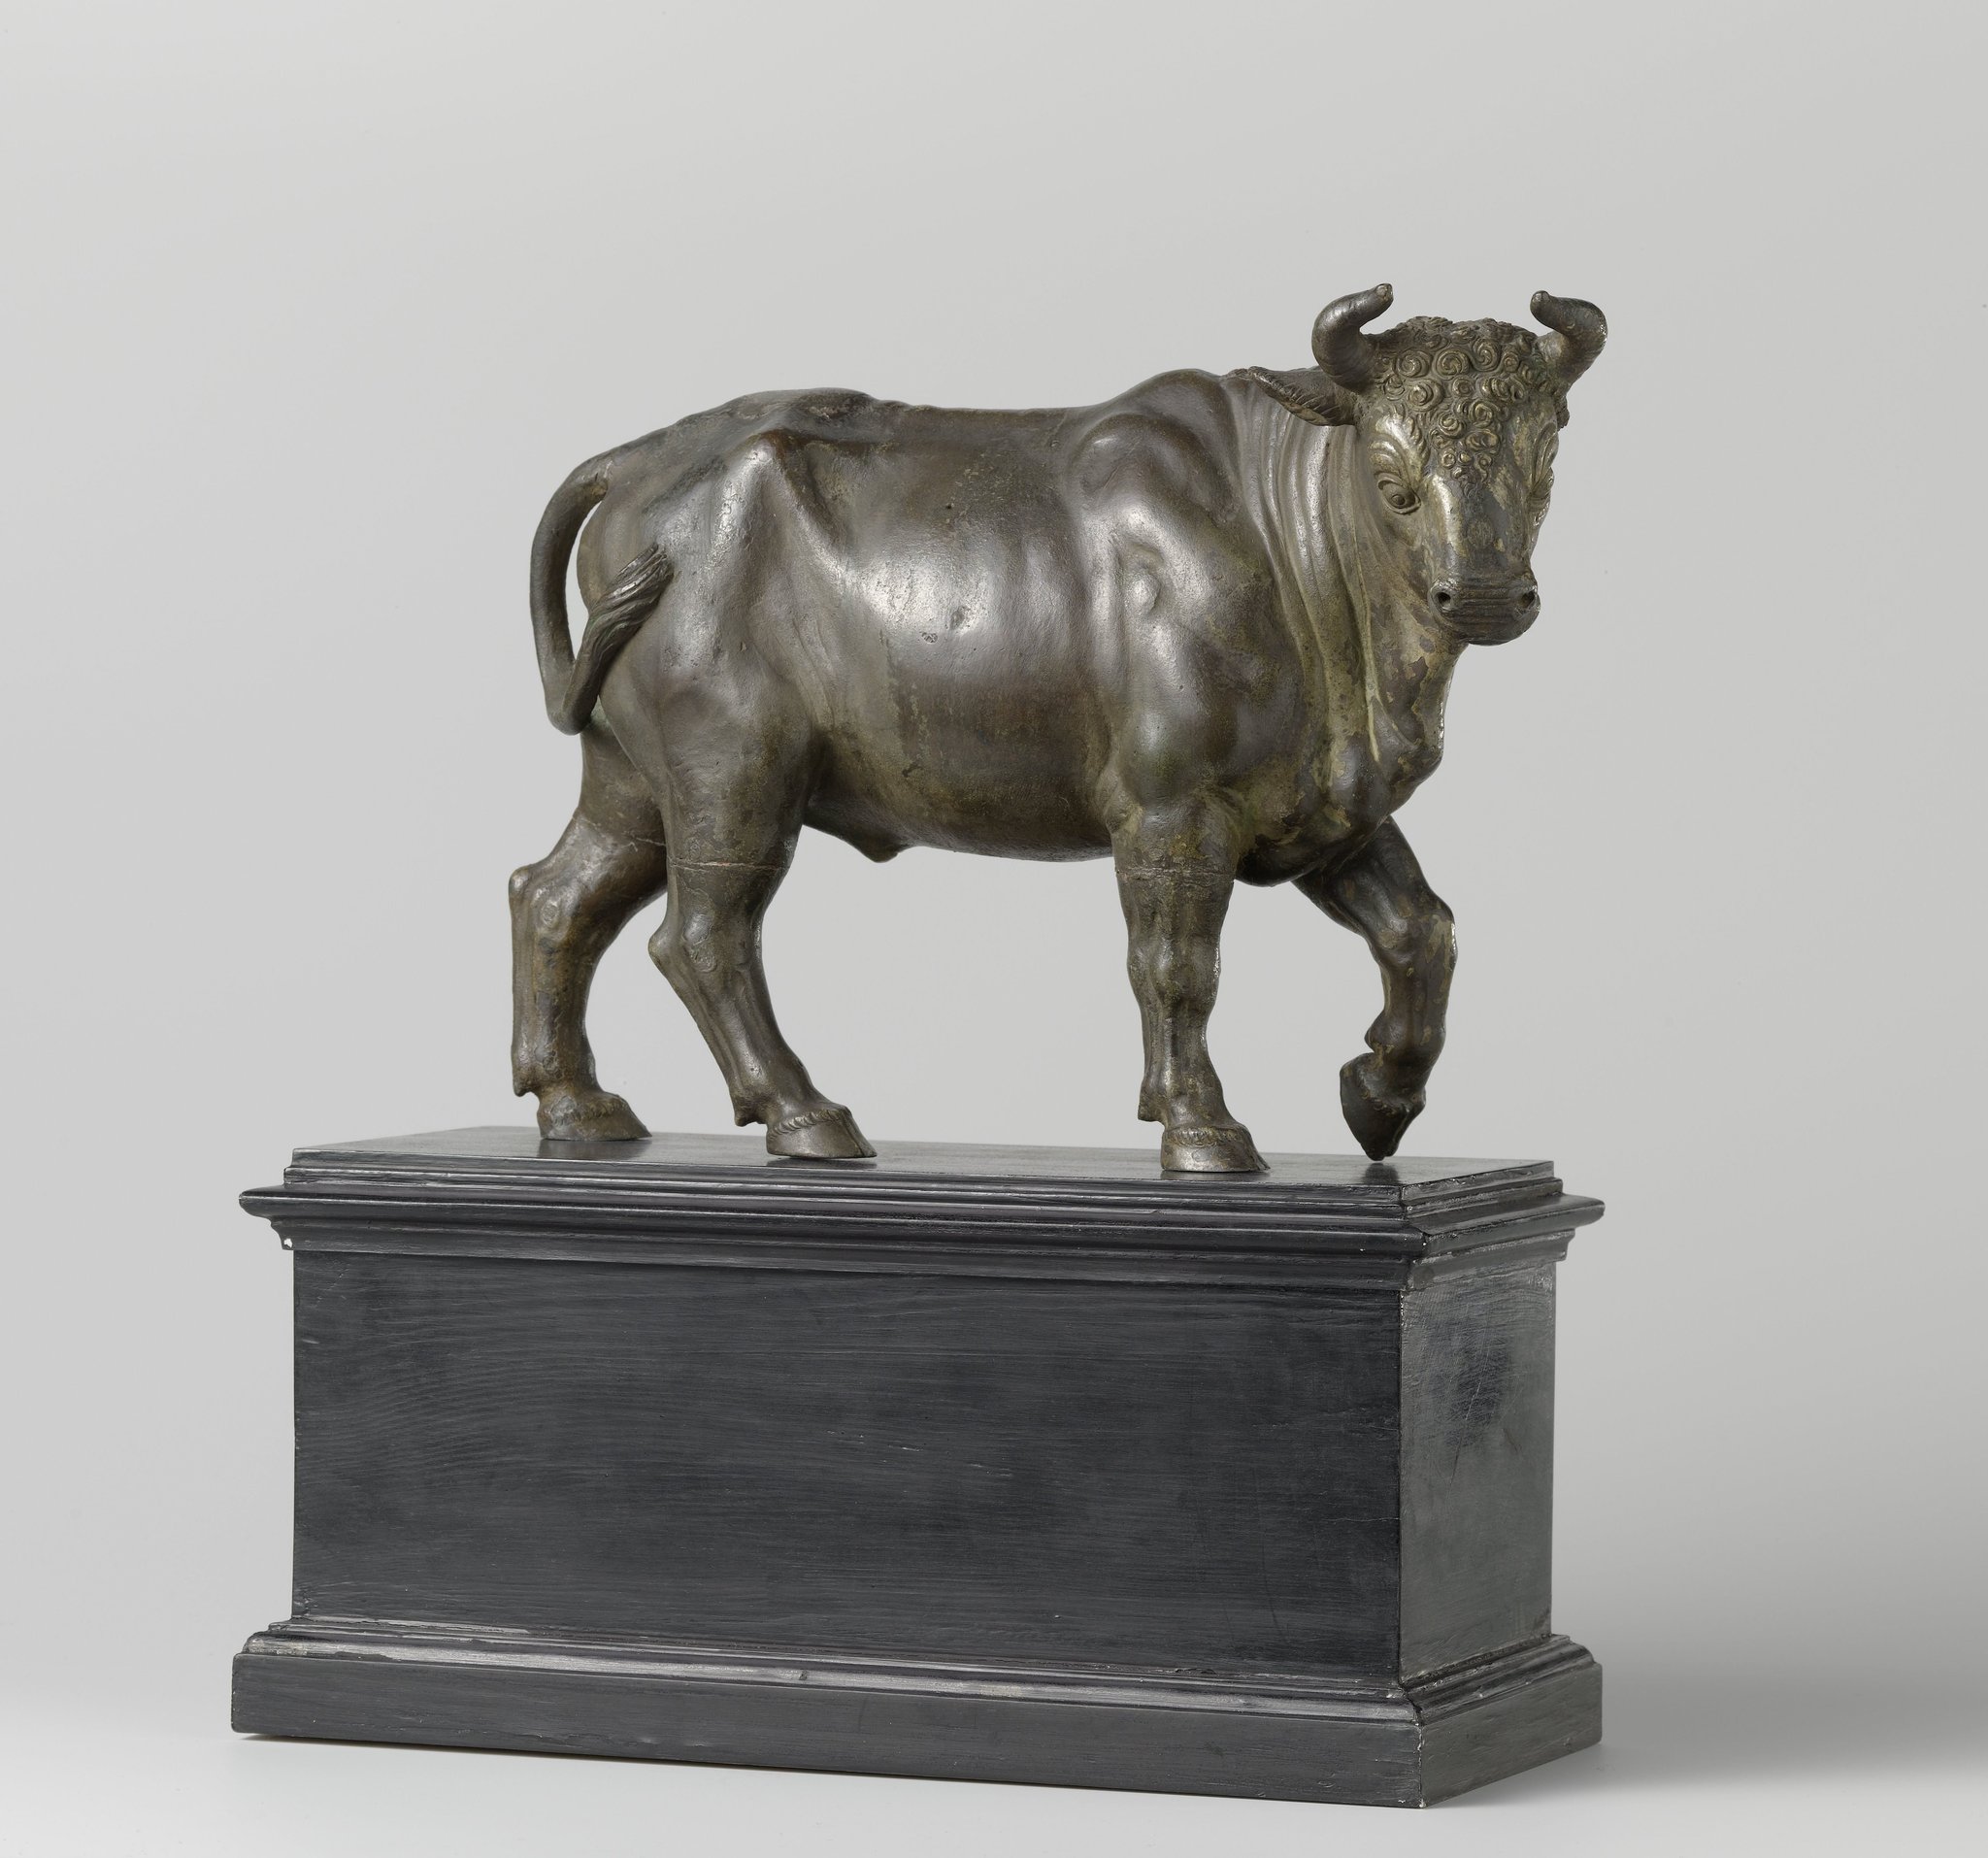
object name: figure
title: Bull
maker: hans reisinger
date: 1590-1598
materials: bronze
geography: augsburg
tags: bull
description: This bull was part of a group of bronze animals that Heinrich Julius, Duke of Braunschweig-Lüneburg (1564–1613), bought for his castle garden. The animals were later incorporated into a fountain; this bull, along with five others, supported a circular basin. The fountain was dismantled, but sixteen animals have been preserved. The bull is modelled on a bronze statue by Giambologna.